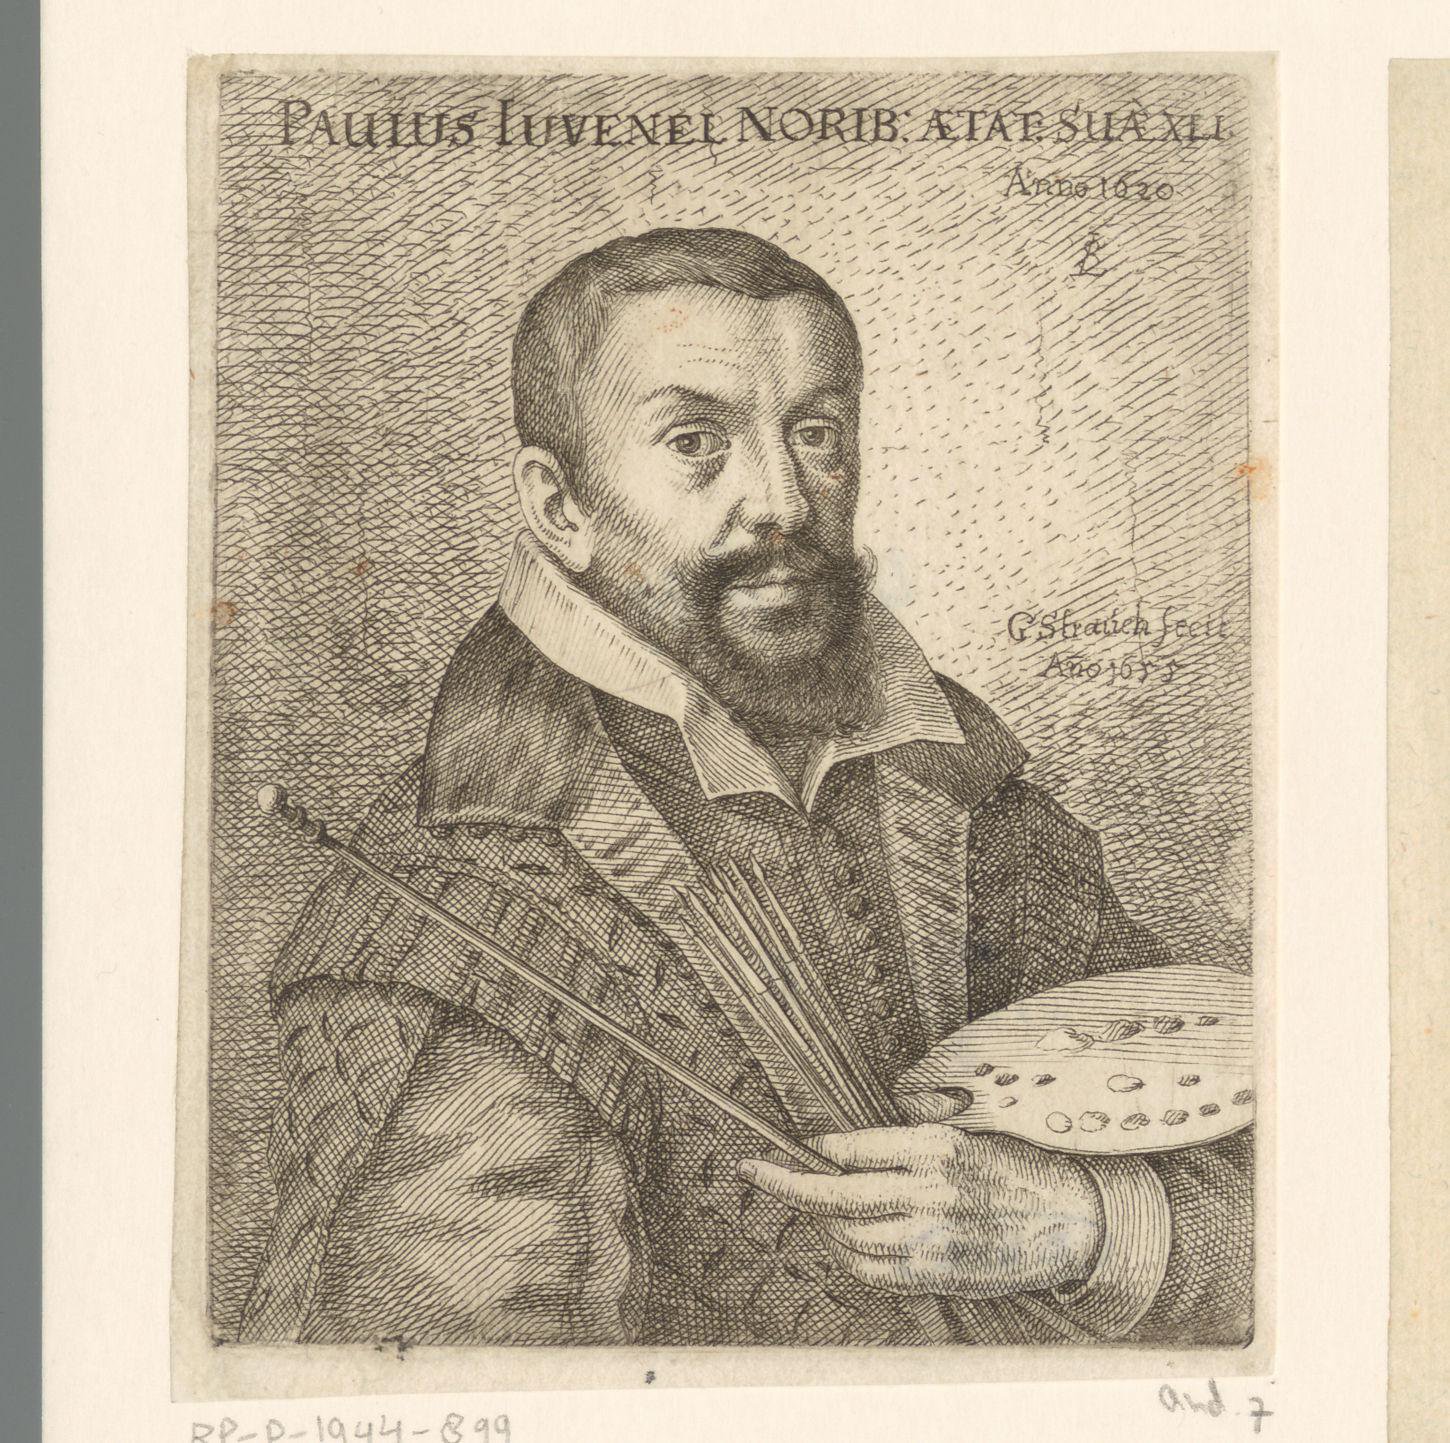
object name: print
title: Portret van Paul Juvenel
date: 1655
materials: paper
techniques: etching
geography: nuremberg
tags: painter, draughtsman, paul juvenel, historical persons, tools, implements of painter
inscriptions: collector's mark: Lugt 2228